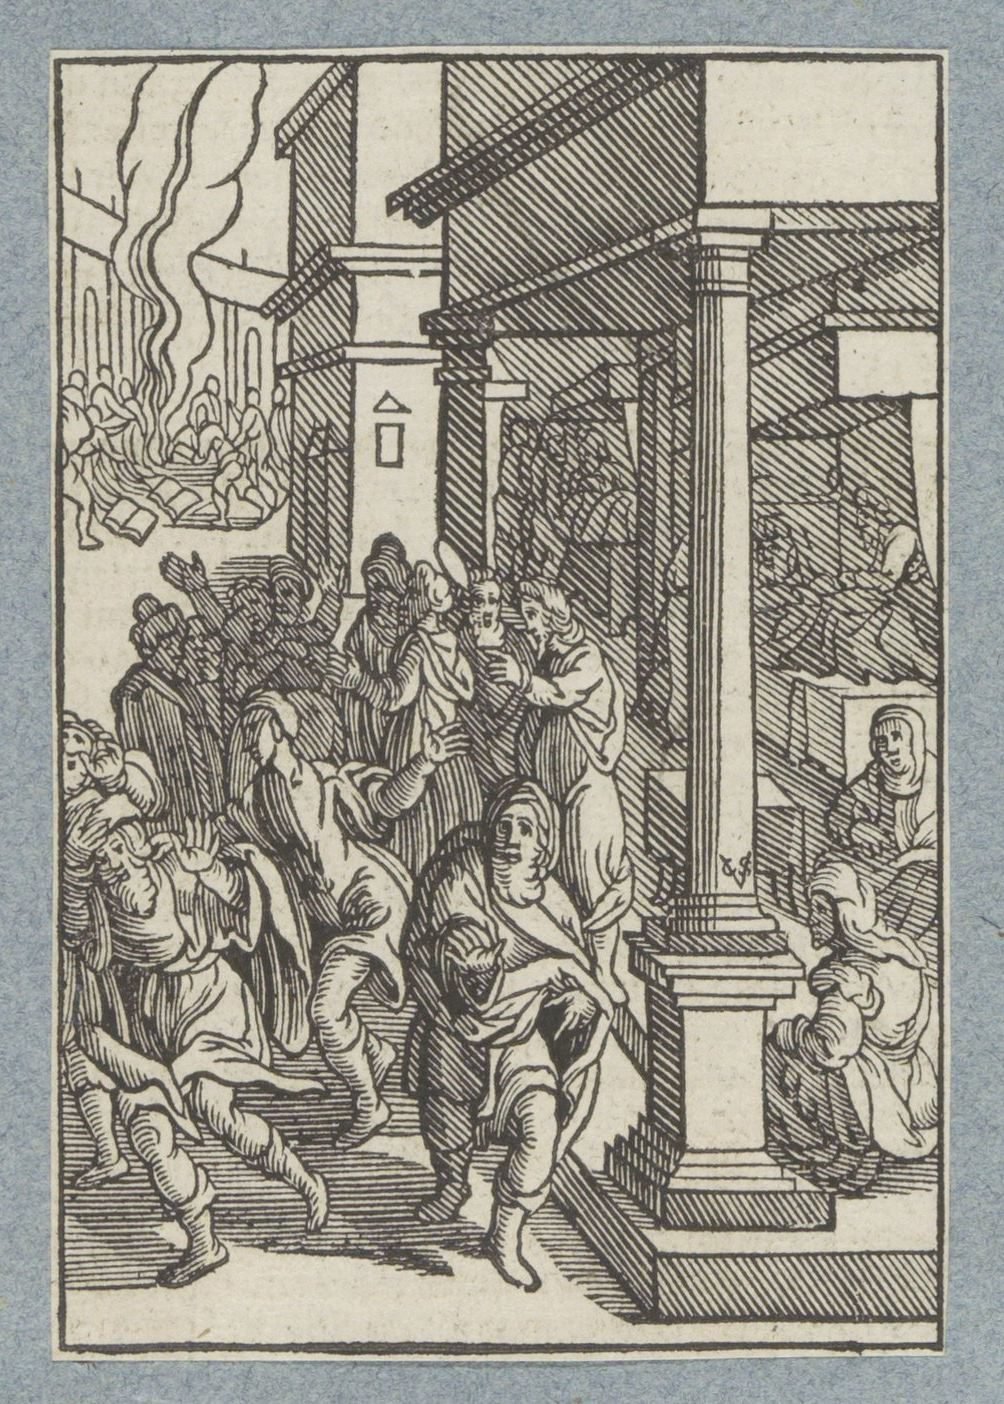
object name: print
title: Paulus drijft de boze geesten uit in Efese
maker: pieter jacobsz. paets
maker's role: publisher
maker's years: 1587-1667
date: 1629-1646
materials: paper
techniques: letterpress printing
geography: antwerp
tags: the ephesians burn the exorcists' books in public, seven exorcists, sons of sceva, are beaten by a man with an evil spirit, and flee, paul's handkerchiefs and aprons cure the sick and possessed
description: De prent is afkomstig uit een van de uitgaven van P.J. Paets uit Amsterdam. De prent wordt mogelijk al gebruikt in: Der Zielen Lust-hof. Leuven, I.Jacbosz voor P.J. Paets [= Amsterdam, P.J. Paets], 1629. Ze komt in ieder geval voor in: Het Nieuwe Testament ons Salichmaeckers Jesu Christi. Amsterdam, P.J. Paets, 1646. De voorstelling is gekopieerd naar een prent van Philips Galle naar Jan van der Straet, onderdeel van de serie getiteld Acta Apostolorum.